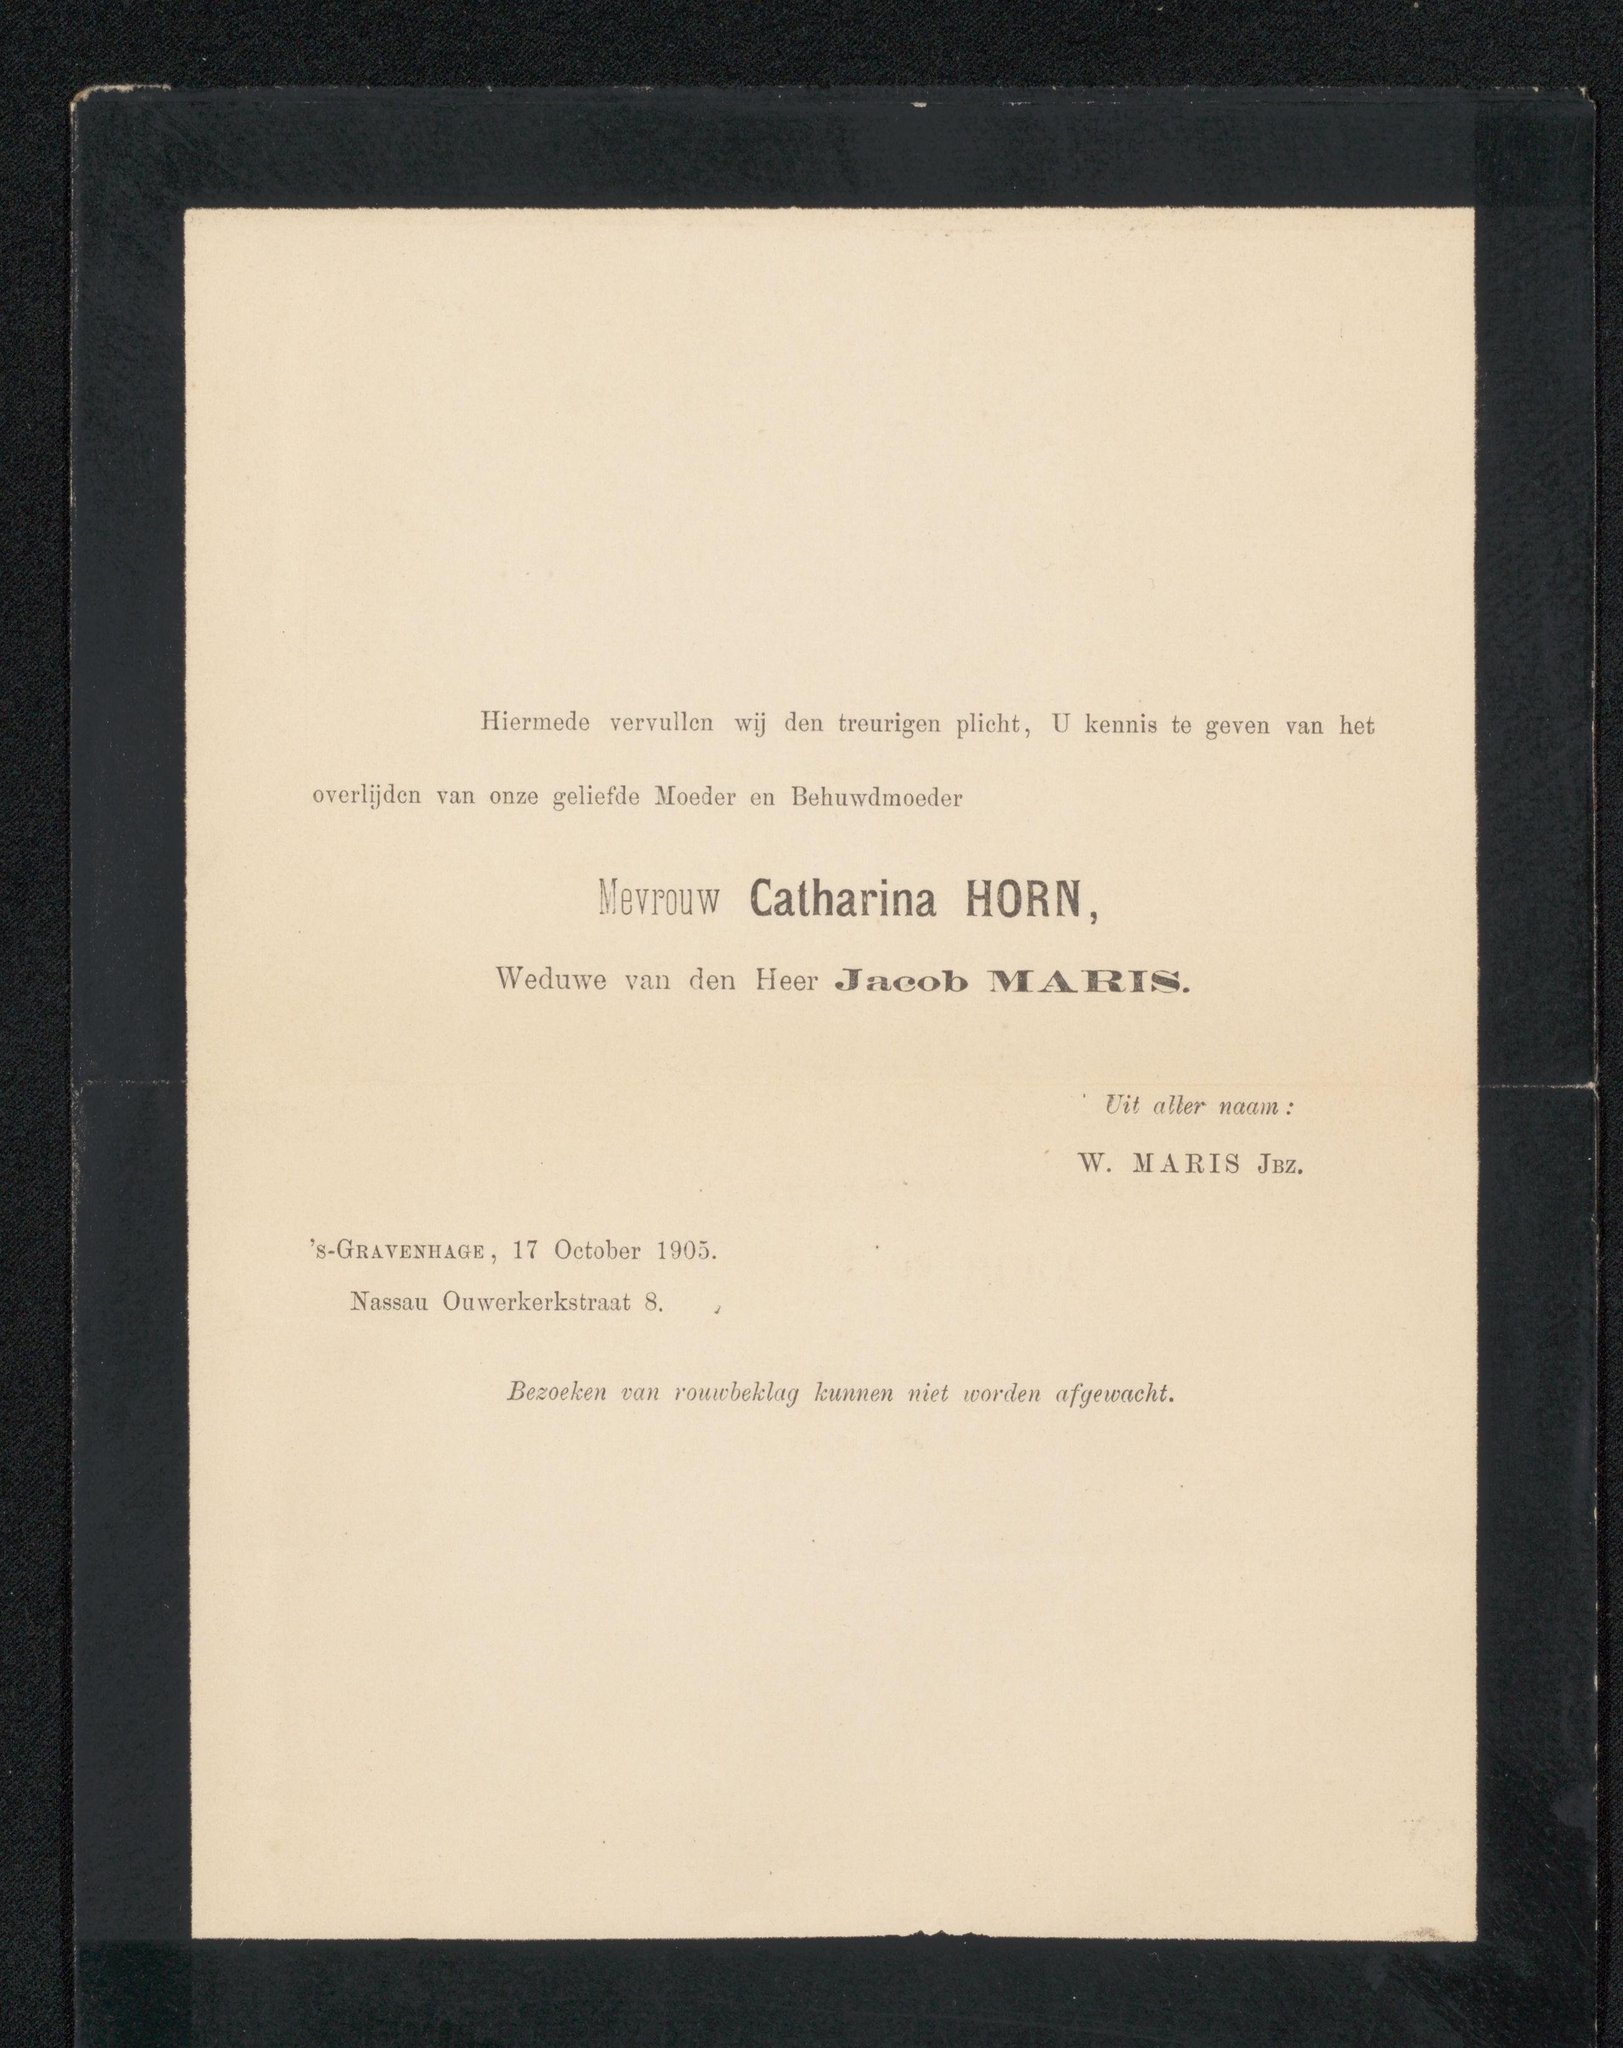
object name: overlijdensbericht, overlijdensadvertentie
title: Overlijdensbericht aan Philip Zilcken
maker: Anonymous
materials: paper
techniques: printing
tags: catharina hendrika maris-horn, the hague, painter, draughtsman, philip zilcken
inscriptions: collector's mark: ‘RPK’